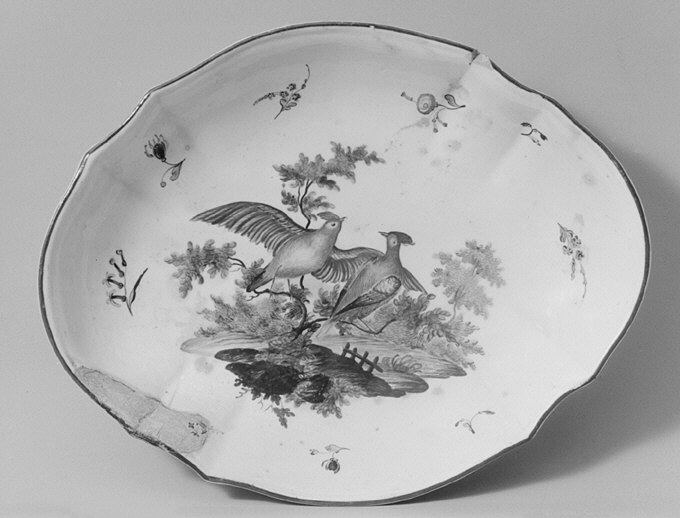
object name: dish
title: Dish (part of a service)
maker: frankenthal porcelain manufactory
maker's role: manufactory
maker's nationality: german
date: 1770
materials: hard paste porcelain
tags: birds,trees